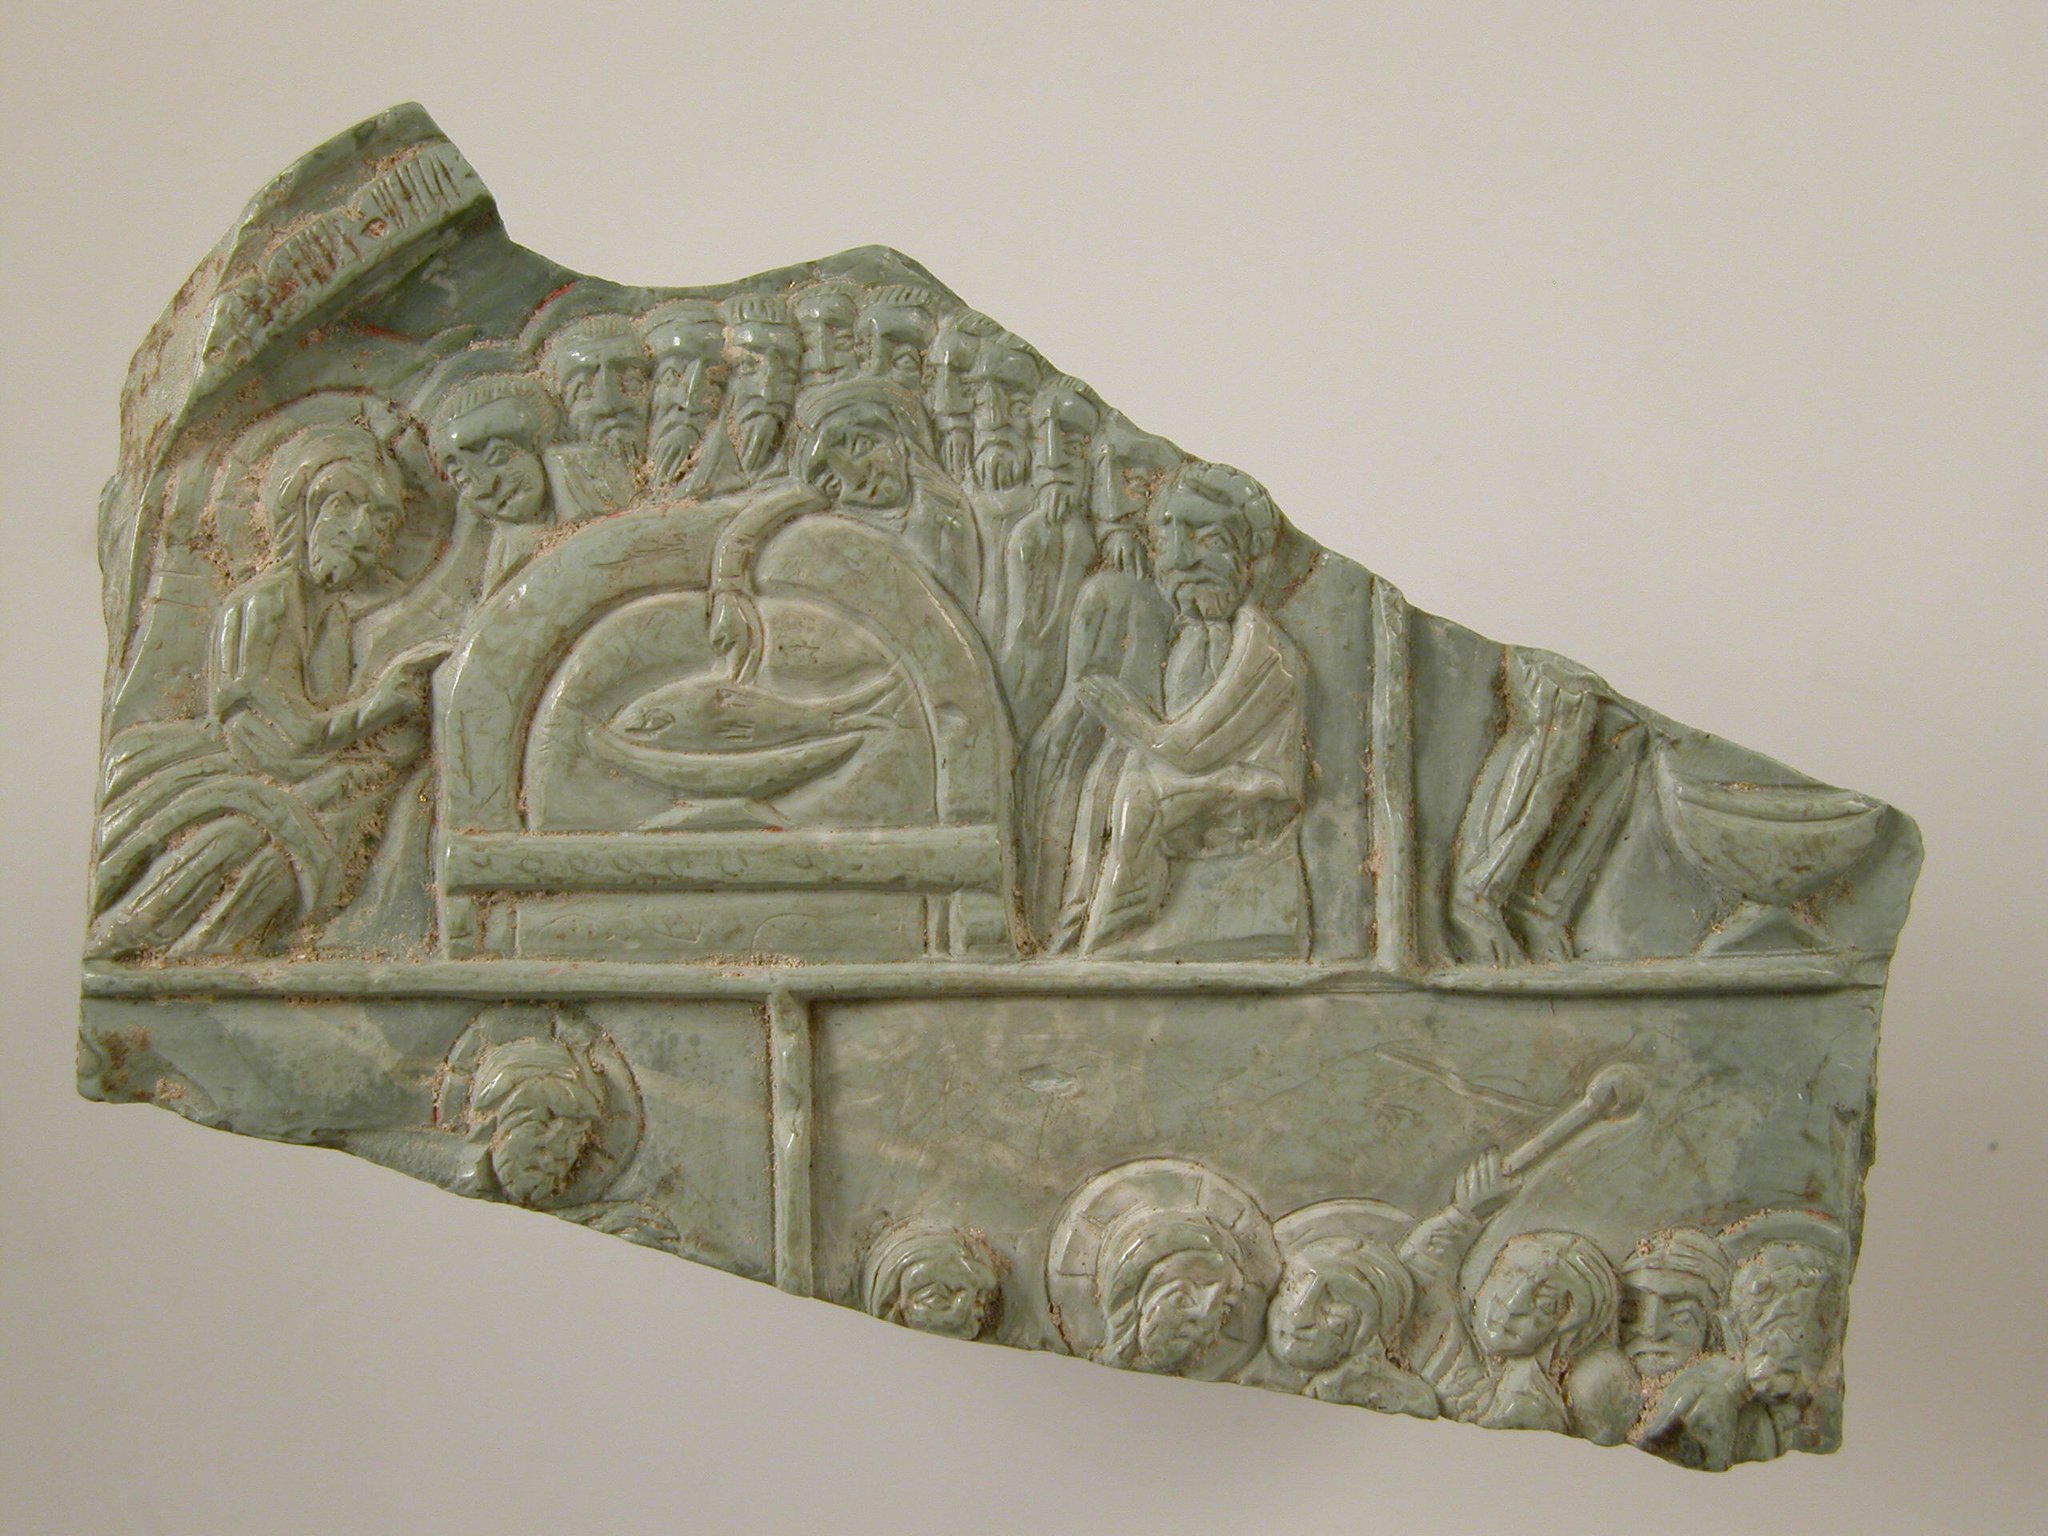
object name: icon fragment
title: Fragment of an Icon with Scenes from the Life of Christ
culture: byzantine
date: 1101-1200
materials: stone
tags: crowd